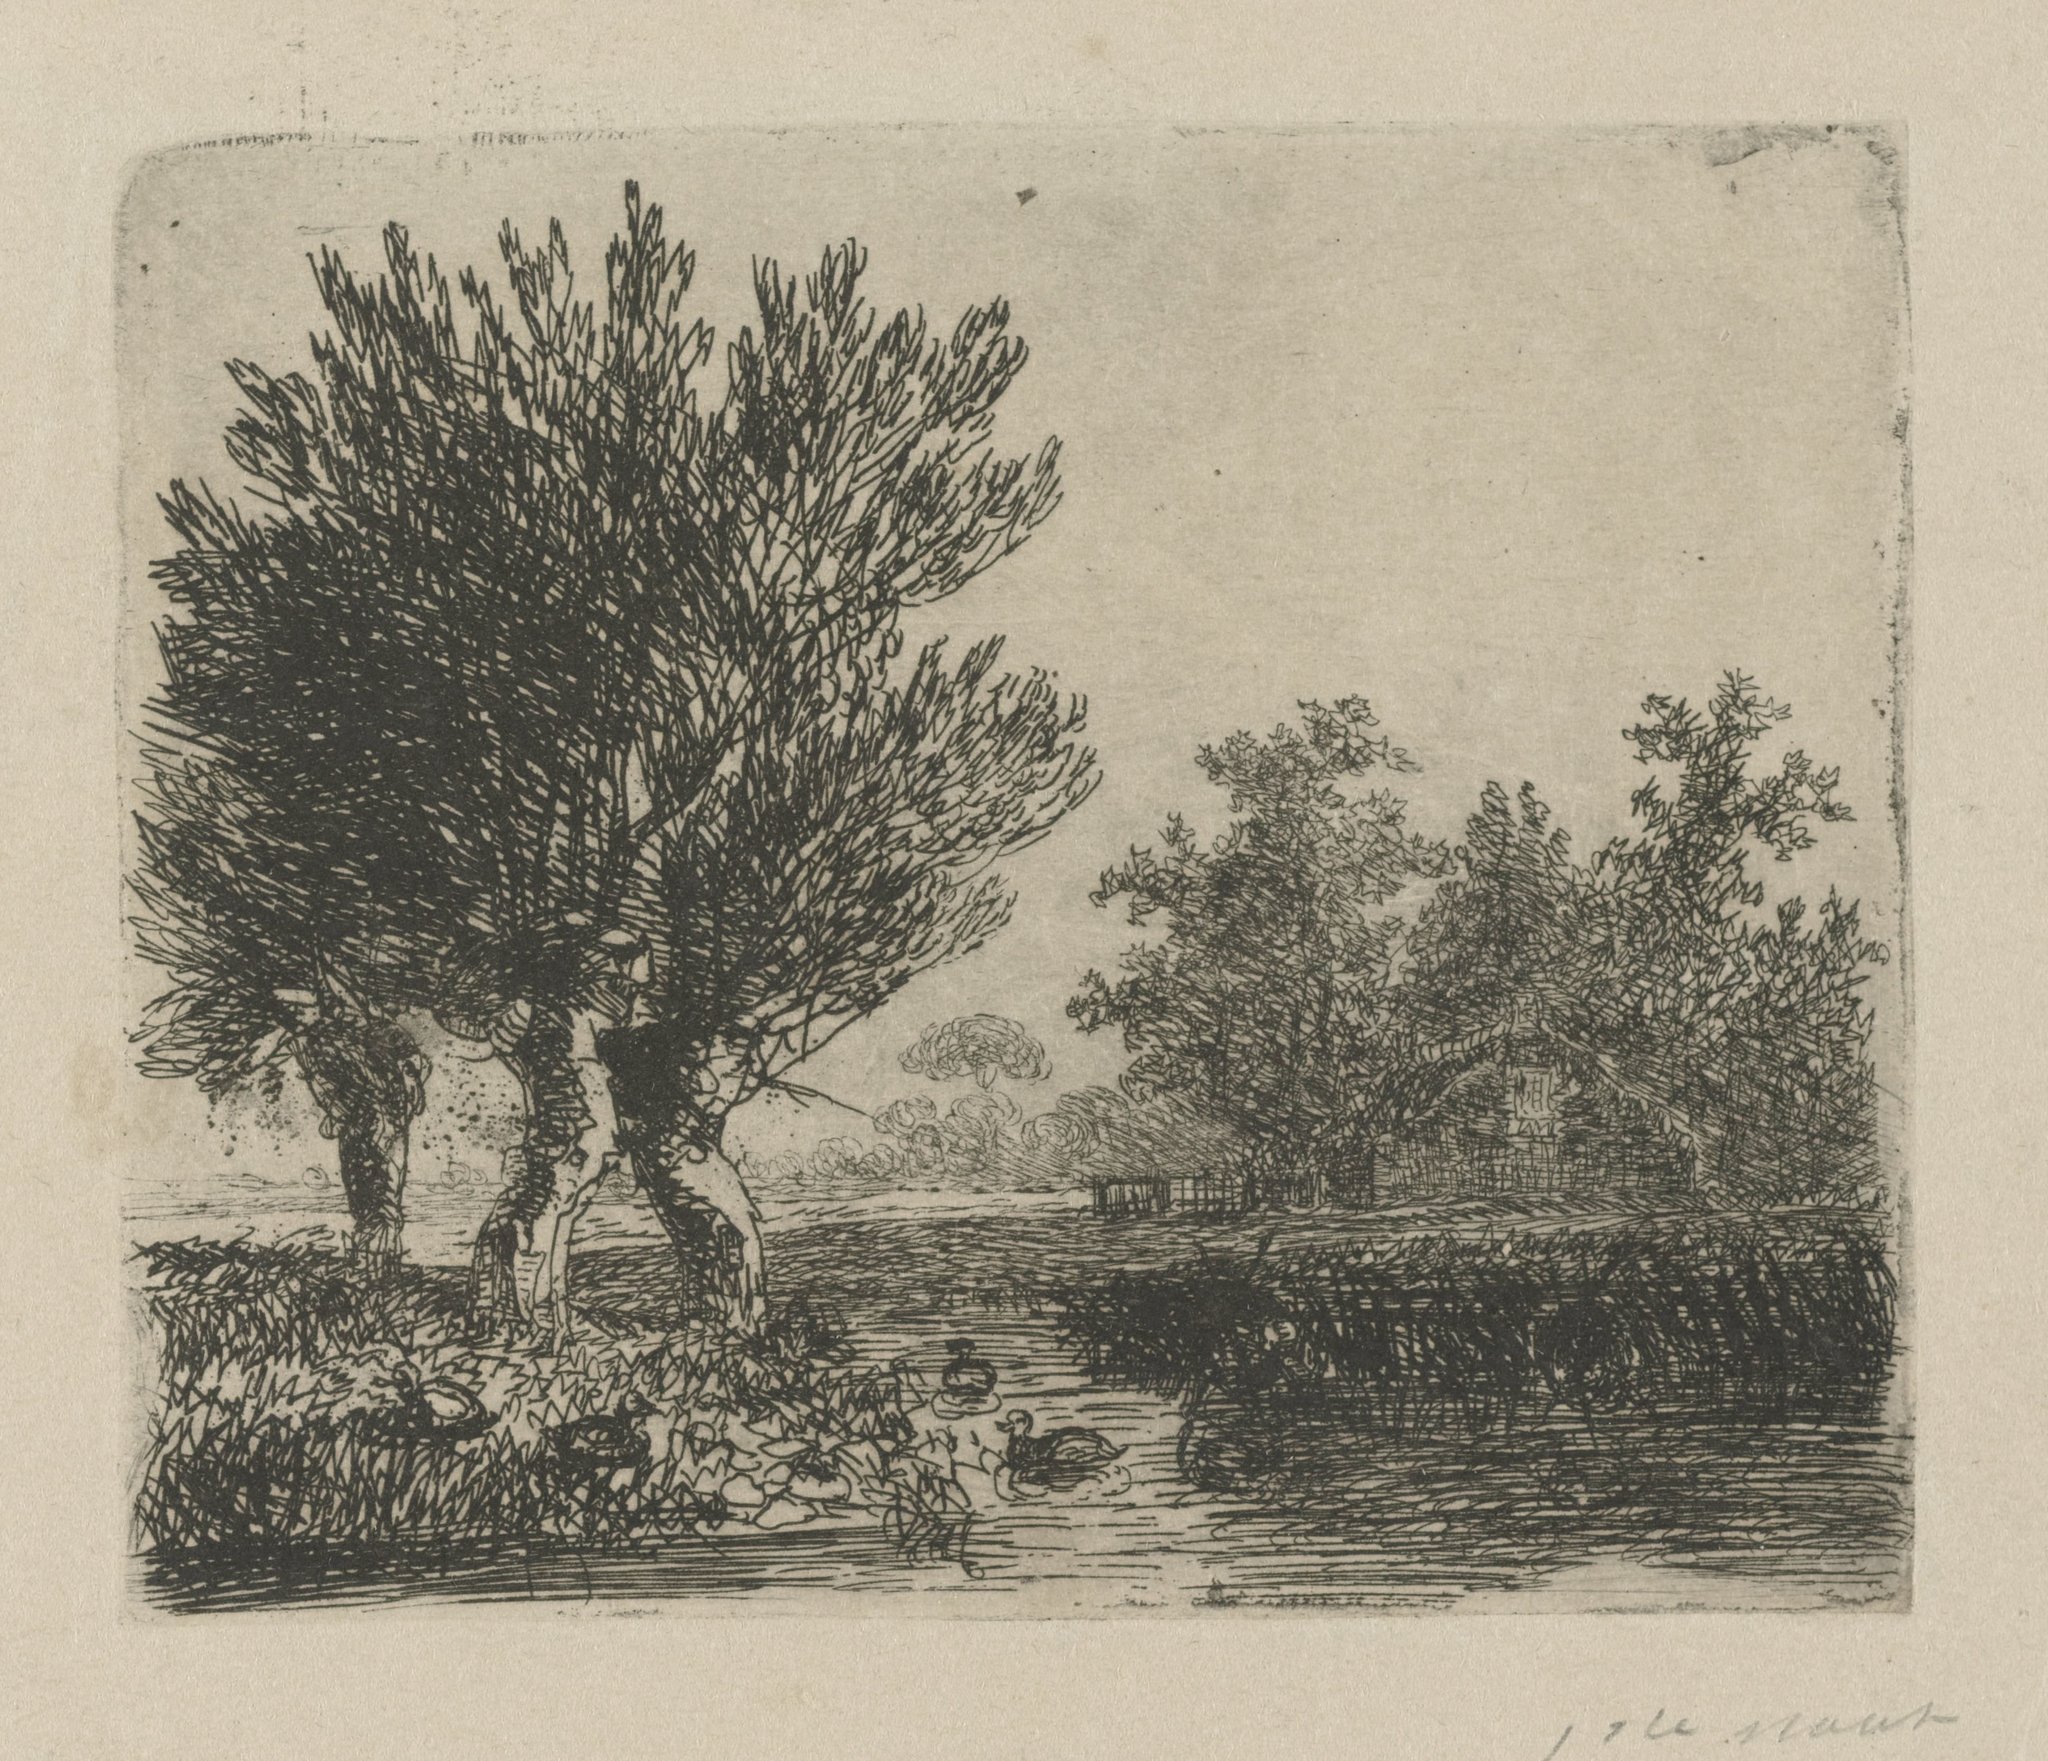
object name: print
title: Drie knotwilgen aan een waterkant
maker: hermanus jan hendrik van rijkelijkhuysen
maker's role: painter, print maker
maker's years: 1813-1883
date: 1823-1883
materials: paper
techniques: drypoint, etching, intaglio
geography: utrecht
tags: brook, trees: willow, farm or solitary house in landscape, water-birds: duck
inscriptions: inscription: ‘1 ste staat’, collector's mark: Lugt 2228